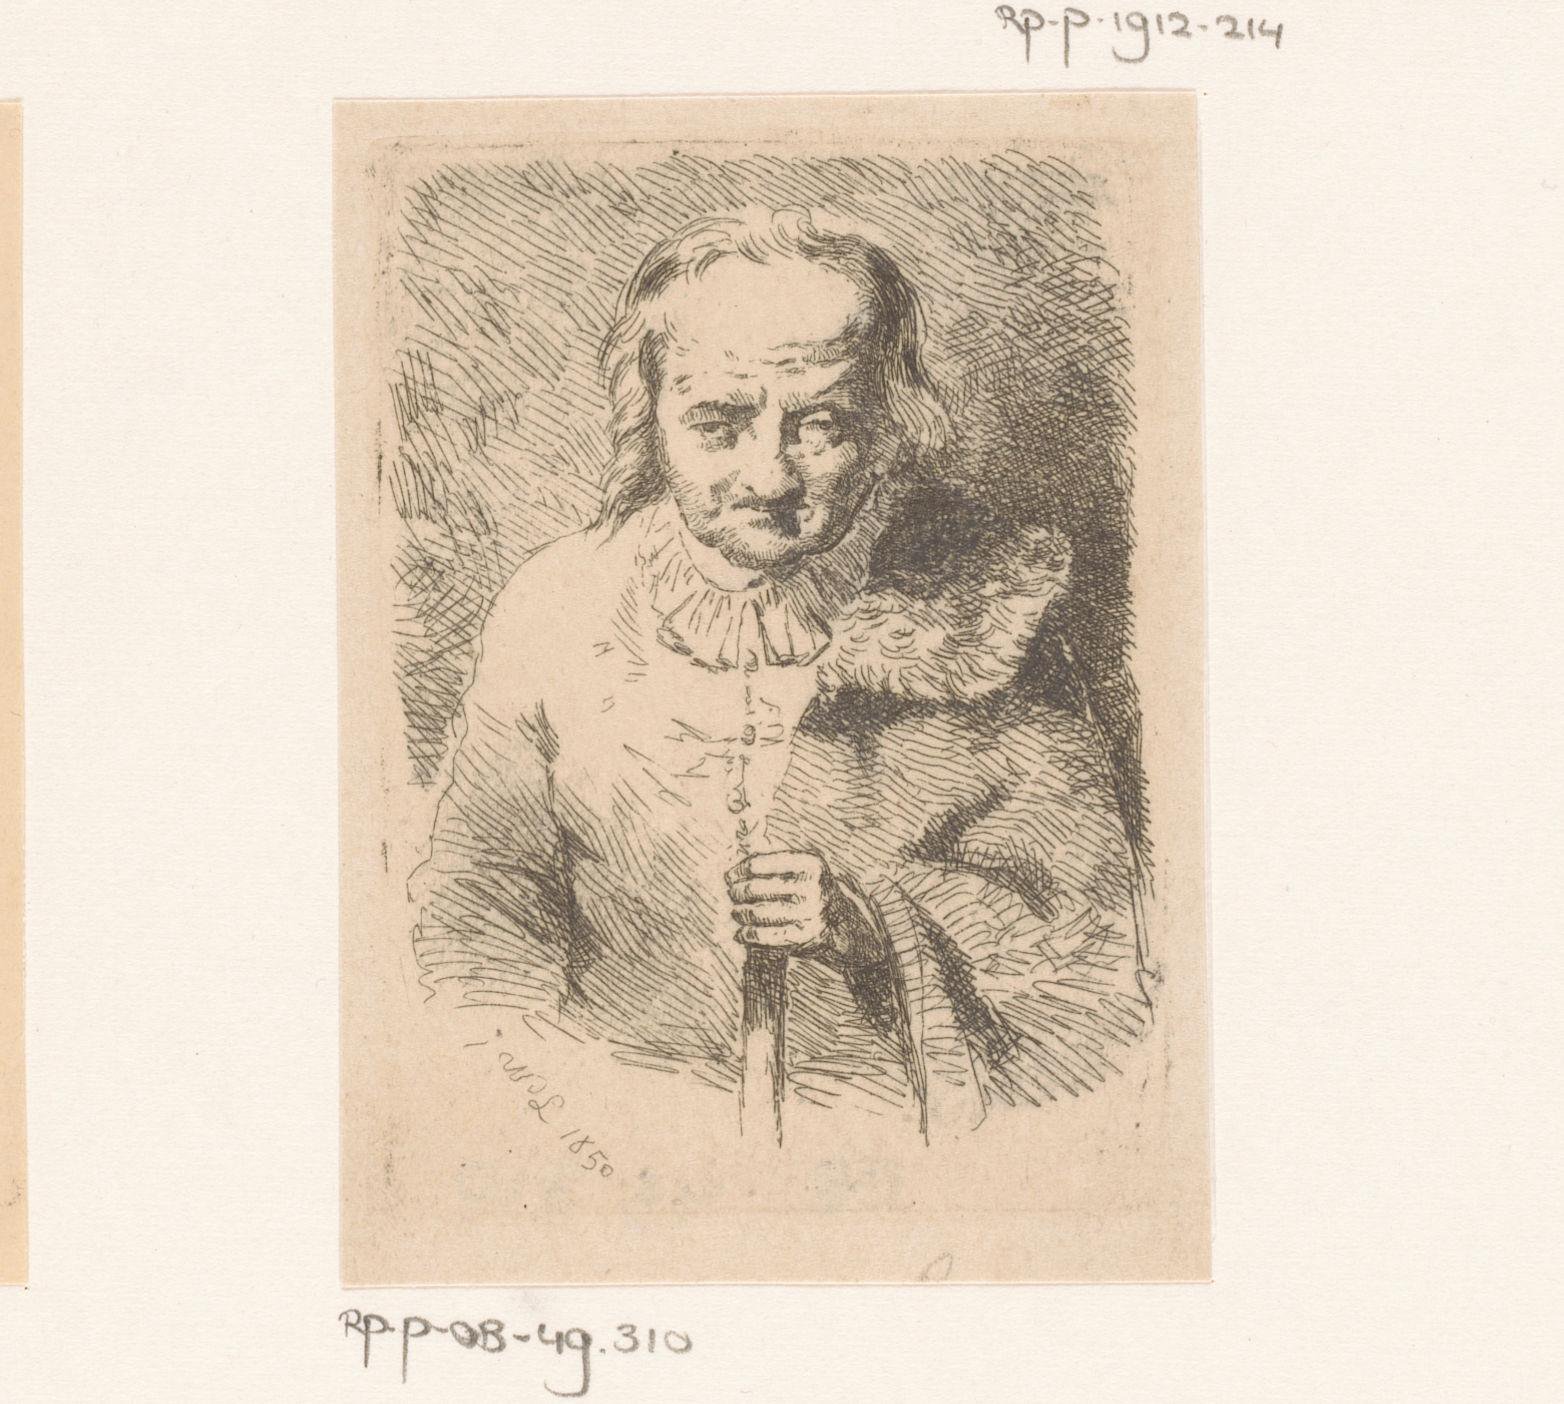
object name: print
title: Oude man met een stok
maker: willem linnig (i)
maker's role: print maker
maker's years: 1819-1885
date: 1850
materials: paper, pencil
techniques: etching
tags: walking-stick, staff, old man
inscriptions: collector's mark: Lugt 2228